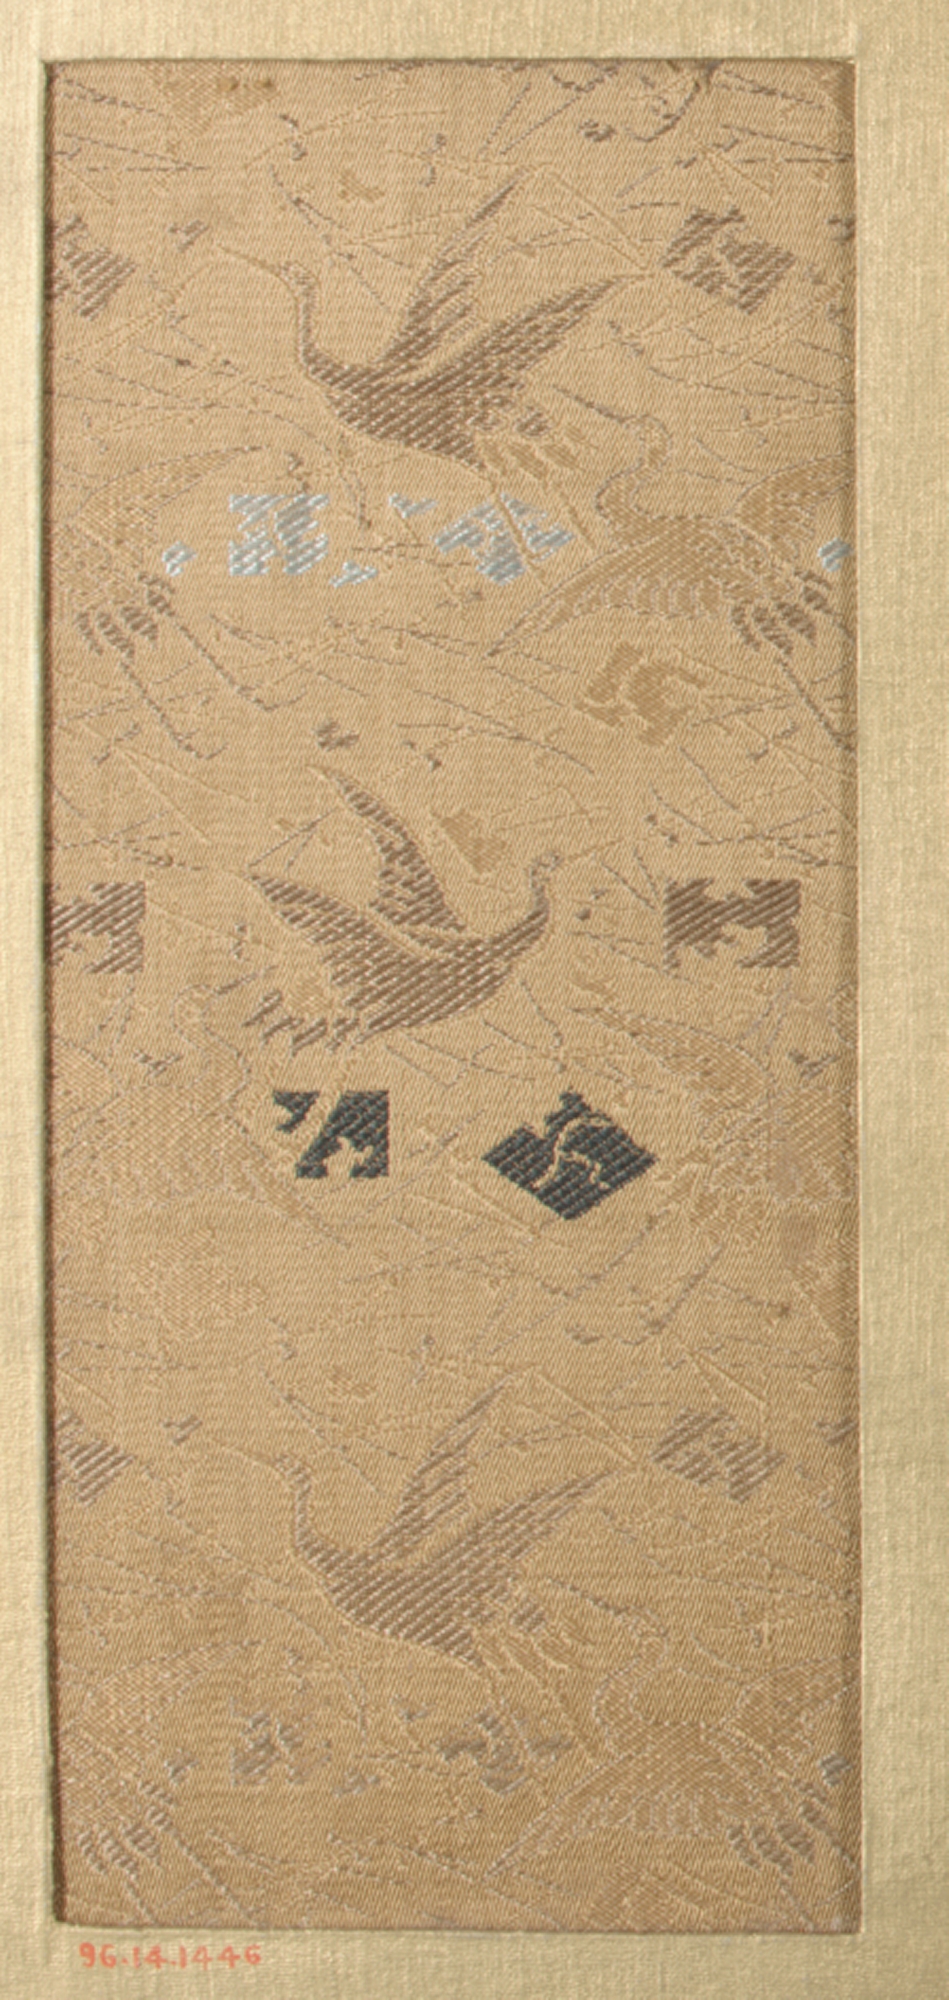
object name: piece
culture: japanese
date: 1701-1900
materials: silk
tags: cranes